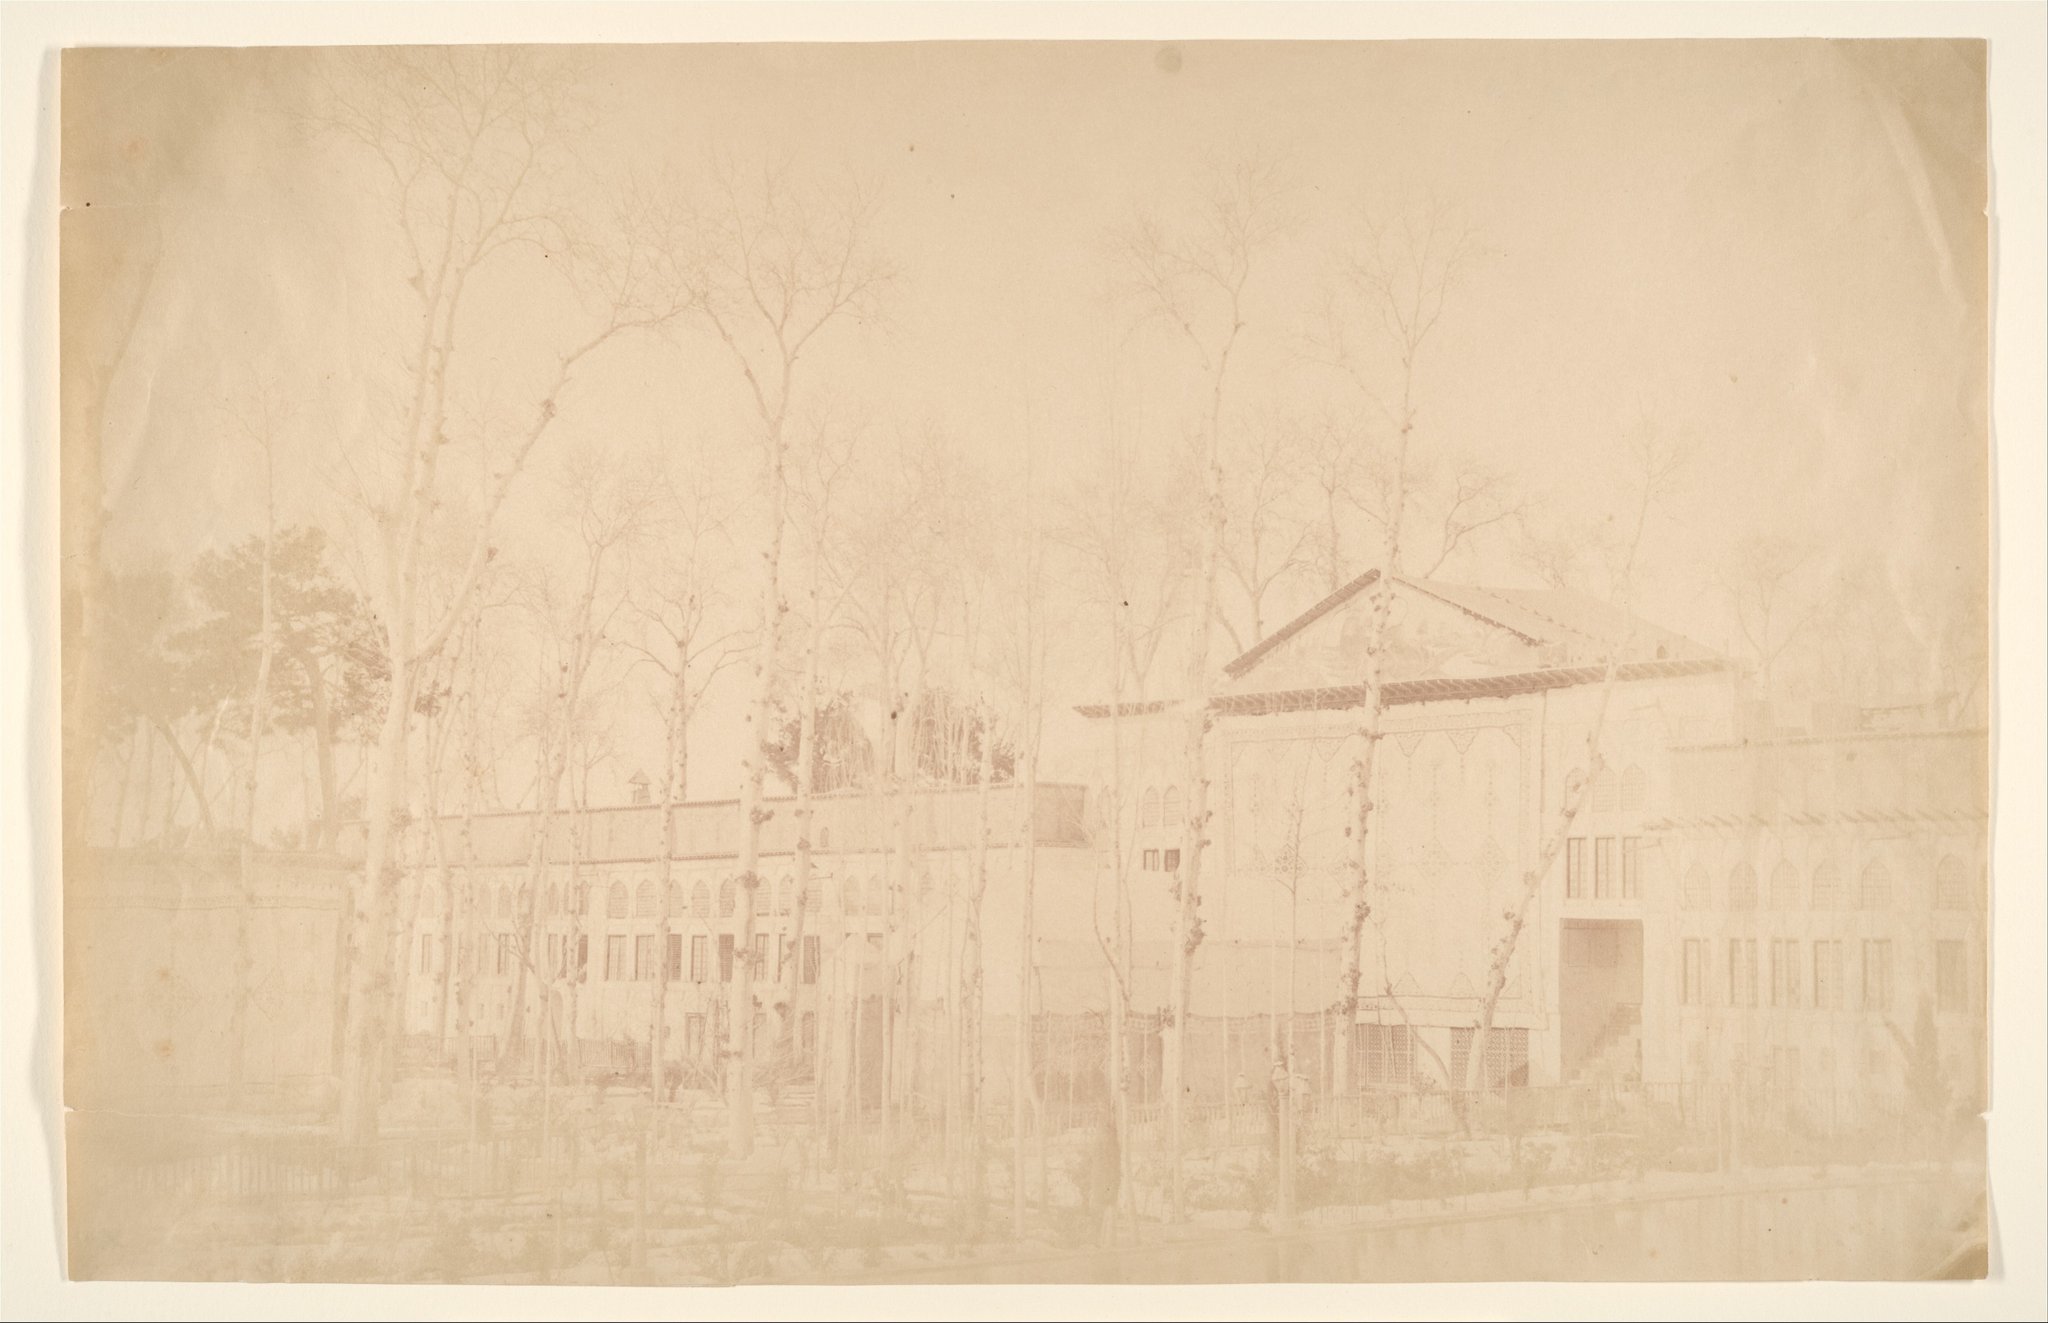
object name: photograph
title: [Golestan Palace, Interior, Teheran, Iran]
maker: luigi pesce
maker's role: artist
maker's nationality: italian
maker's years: 1818-1891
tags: architecture,palaces